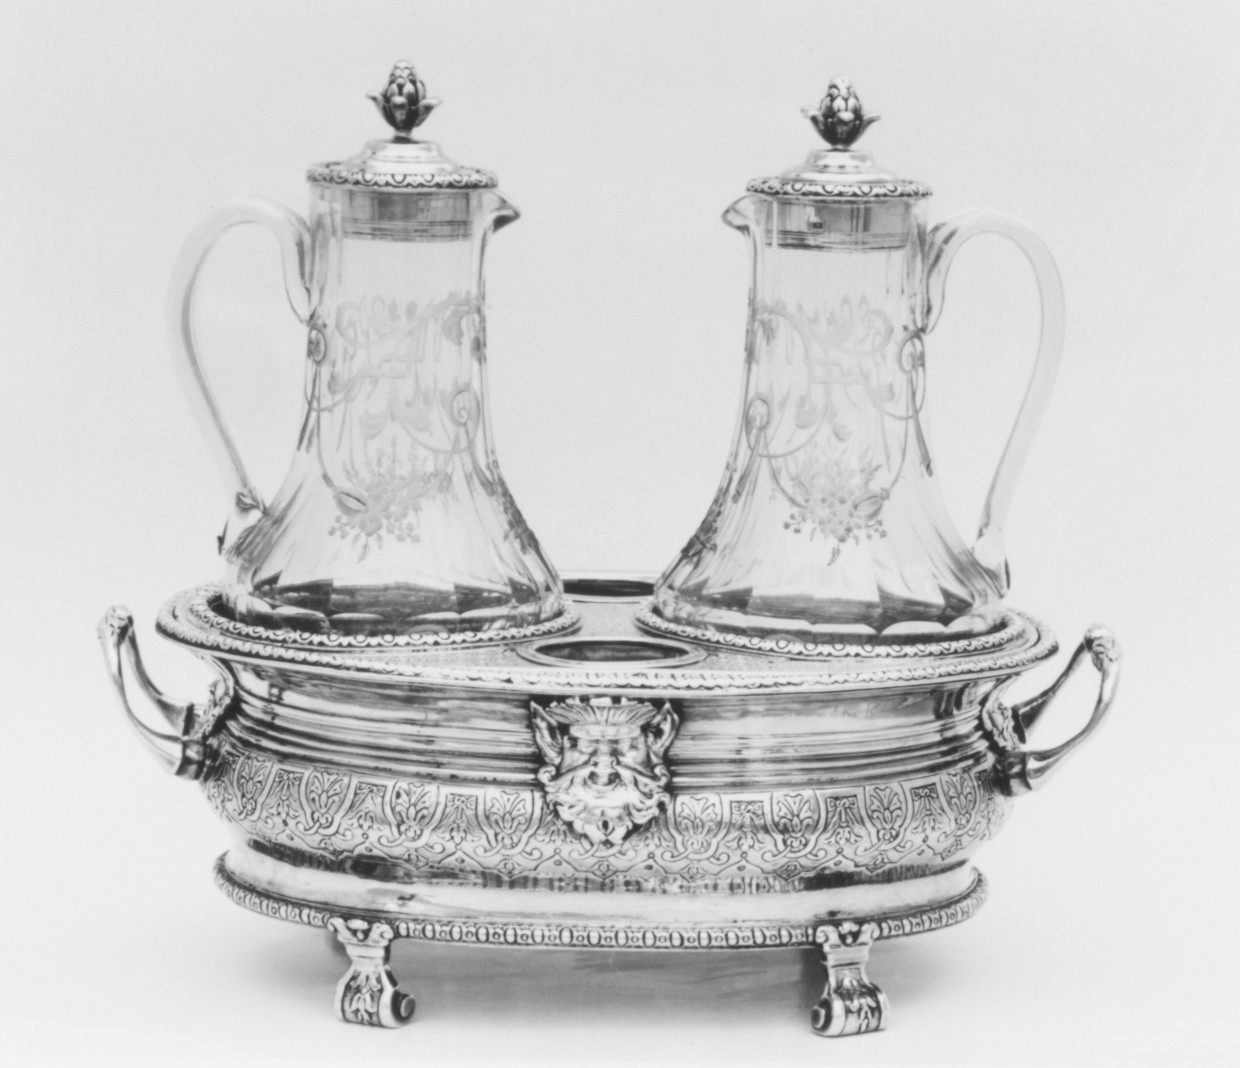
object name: cruet frame and bottle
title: Cruet frame with later glass bottles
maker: richard jarry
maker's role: maker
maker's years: 1678-1759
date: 1717-1722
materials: silver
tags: coat of arms